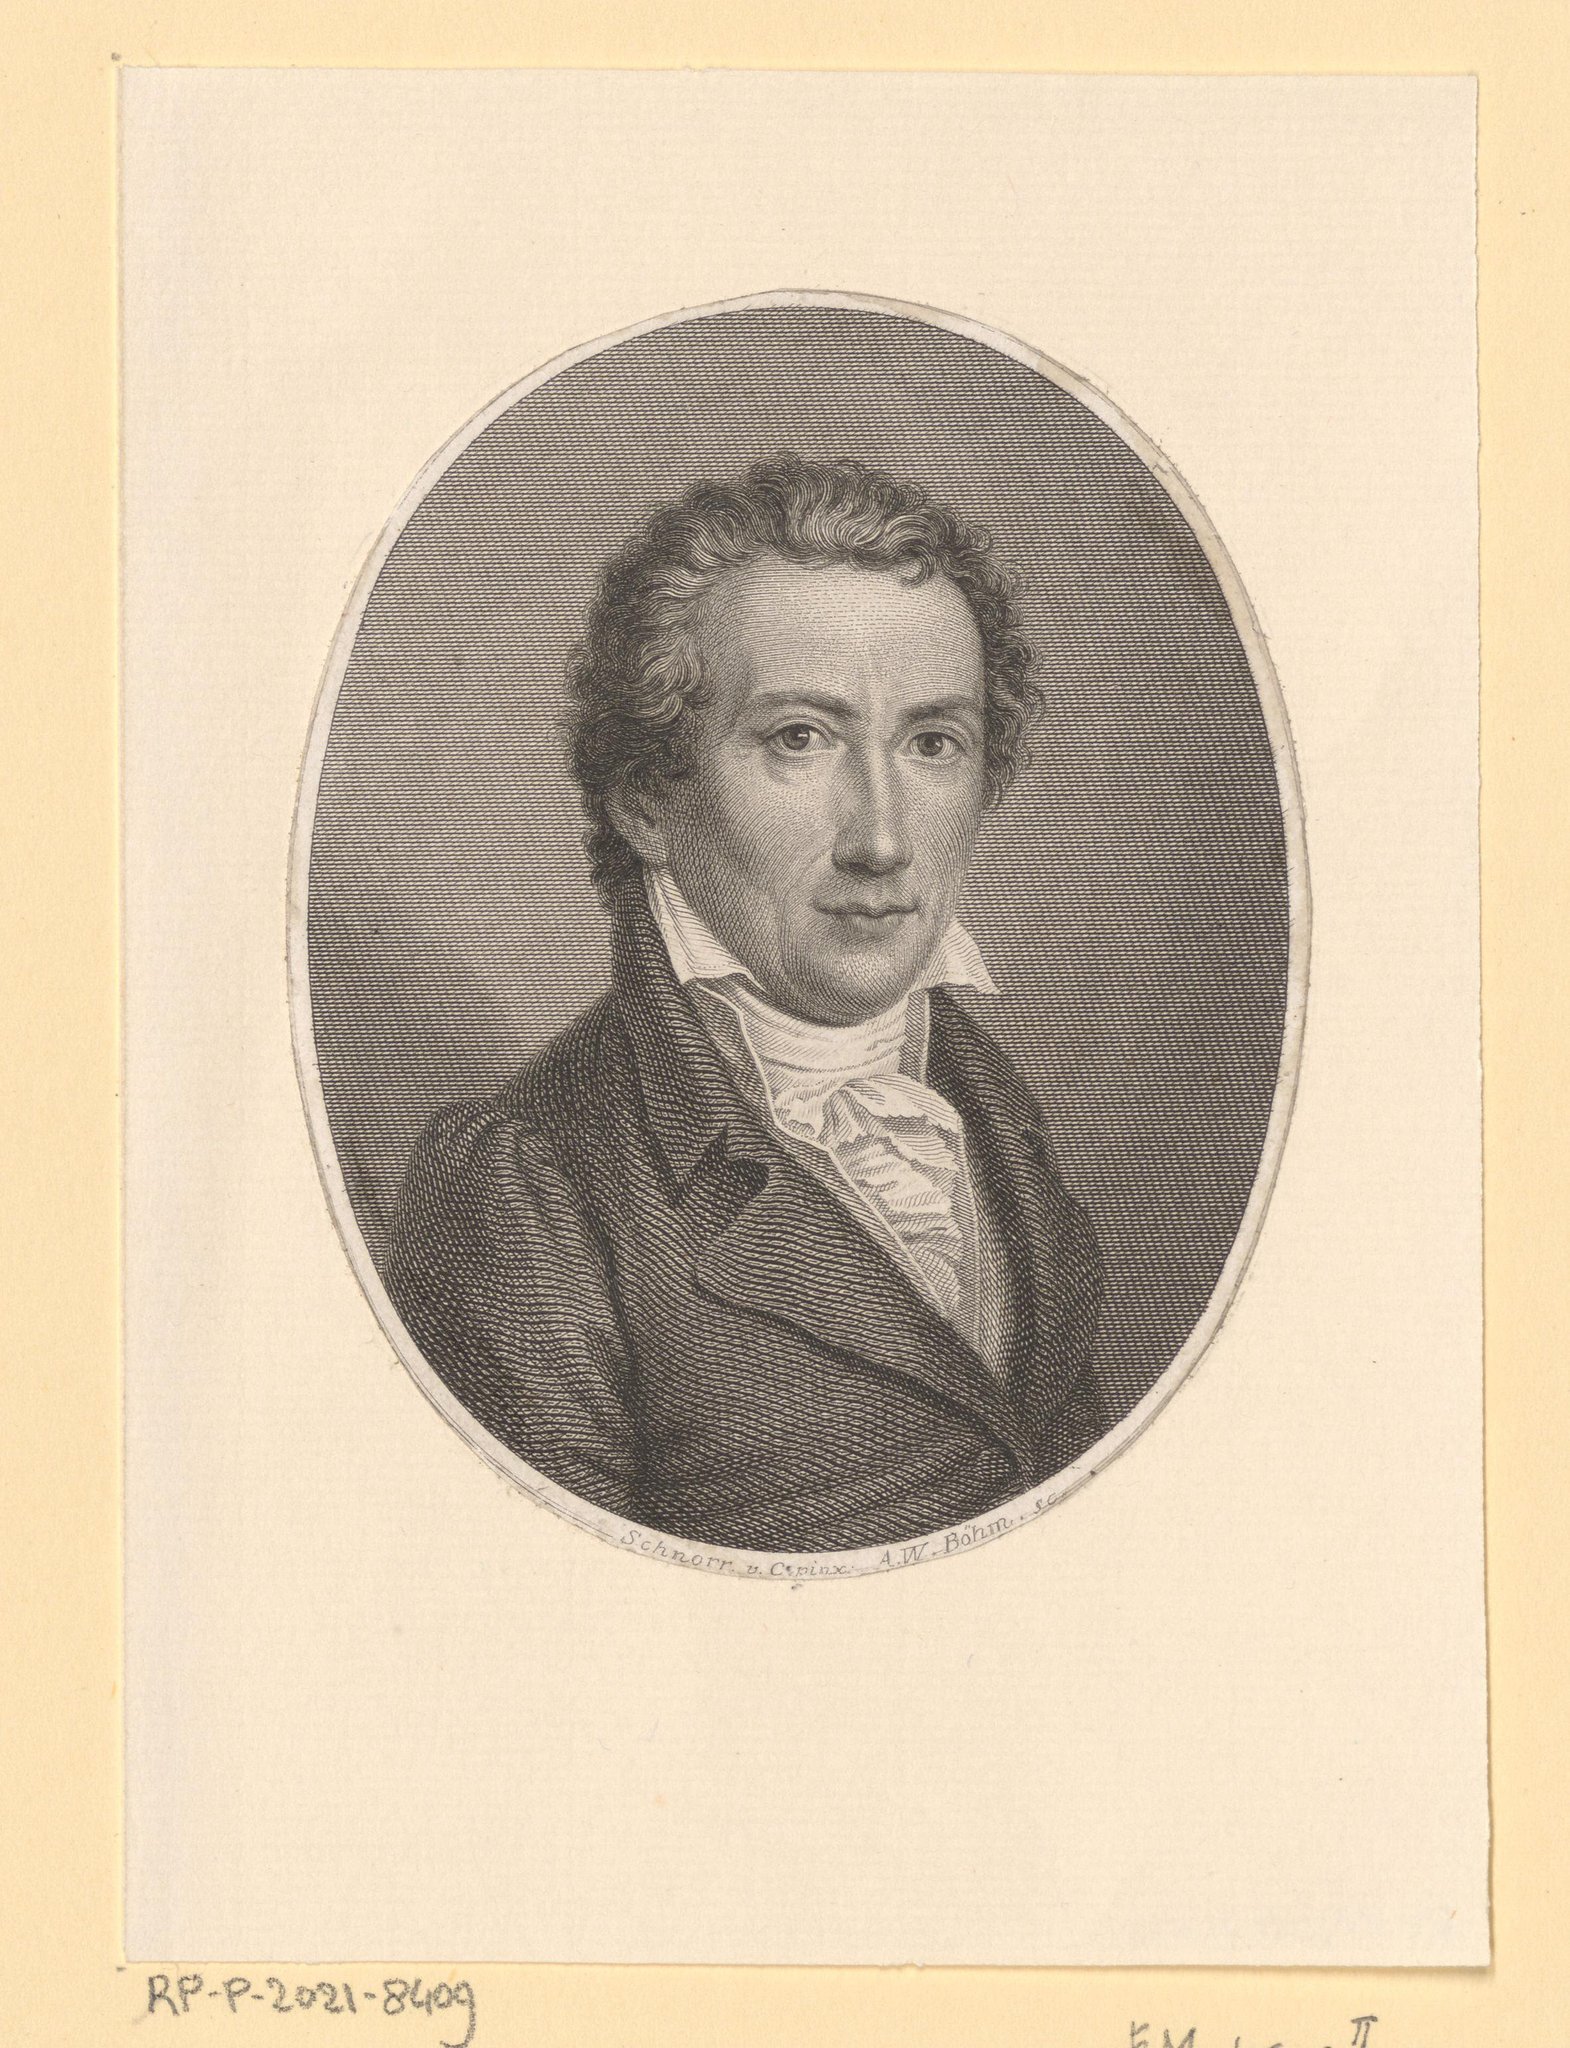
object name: print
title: Portret van Friedrich Rochlitz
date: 1797-1823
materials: paper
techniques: engraving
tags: publisher, historical persons